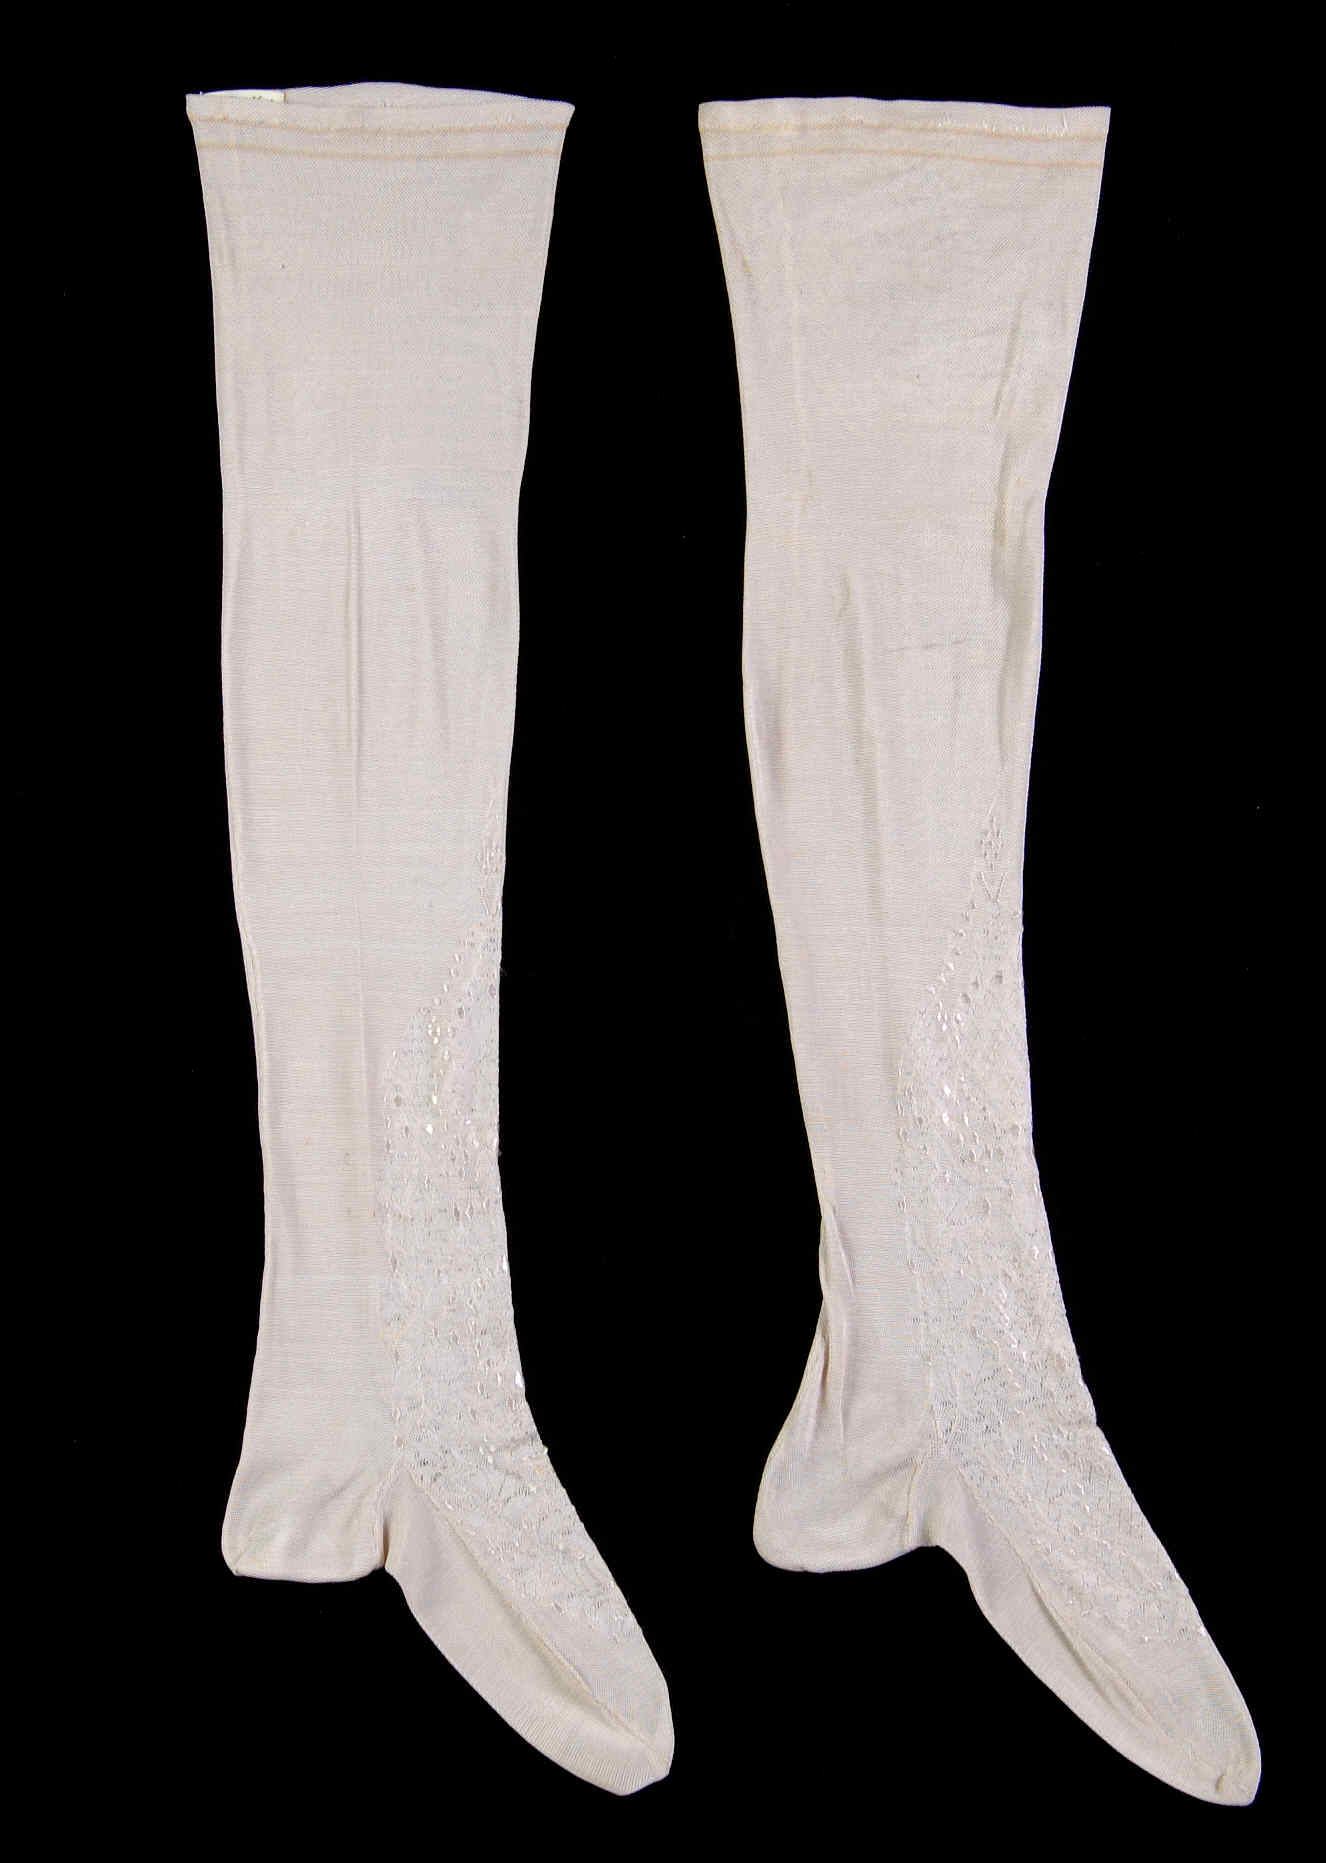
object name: stocking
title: Stockings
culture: french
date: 1850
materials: silk